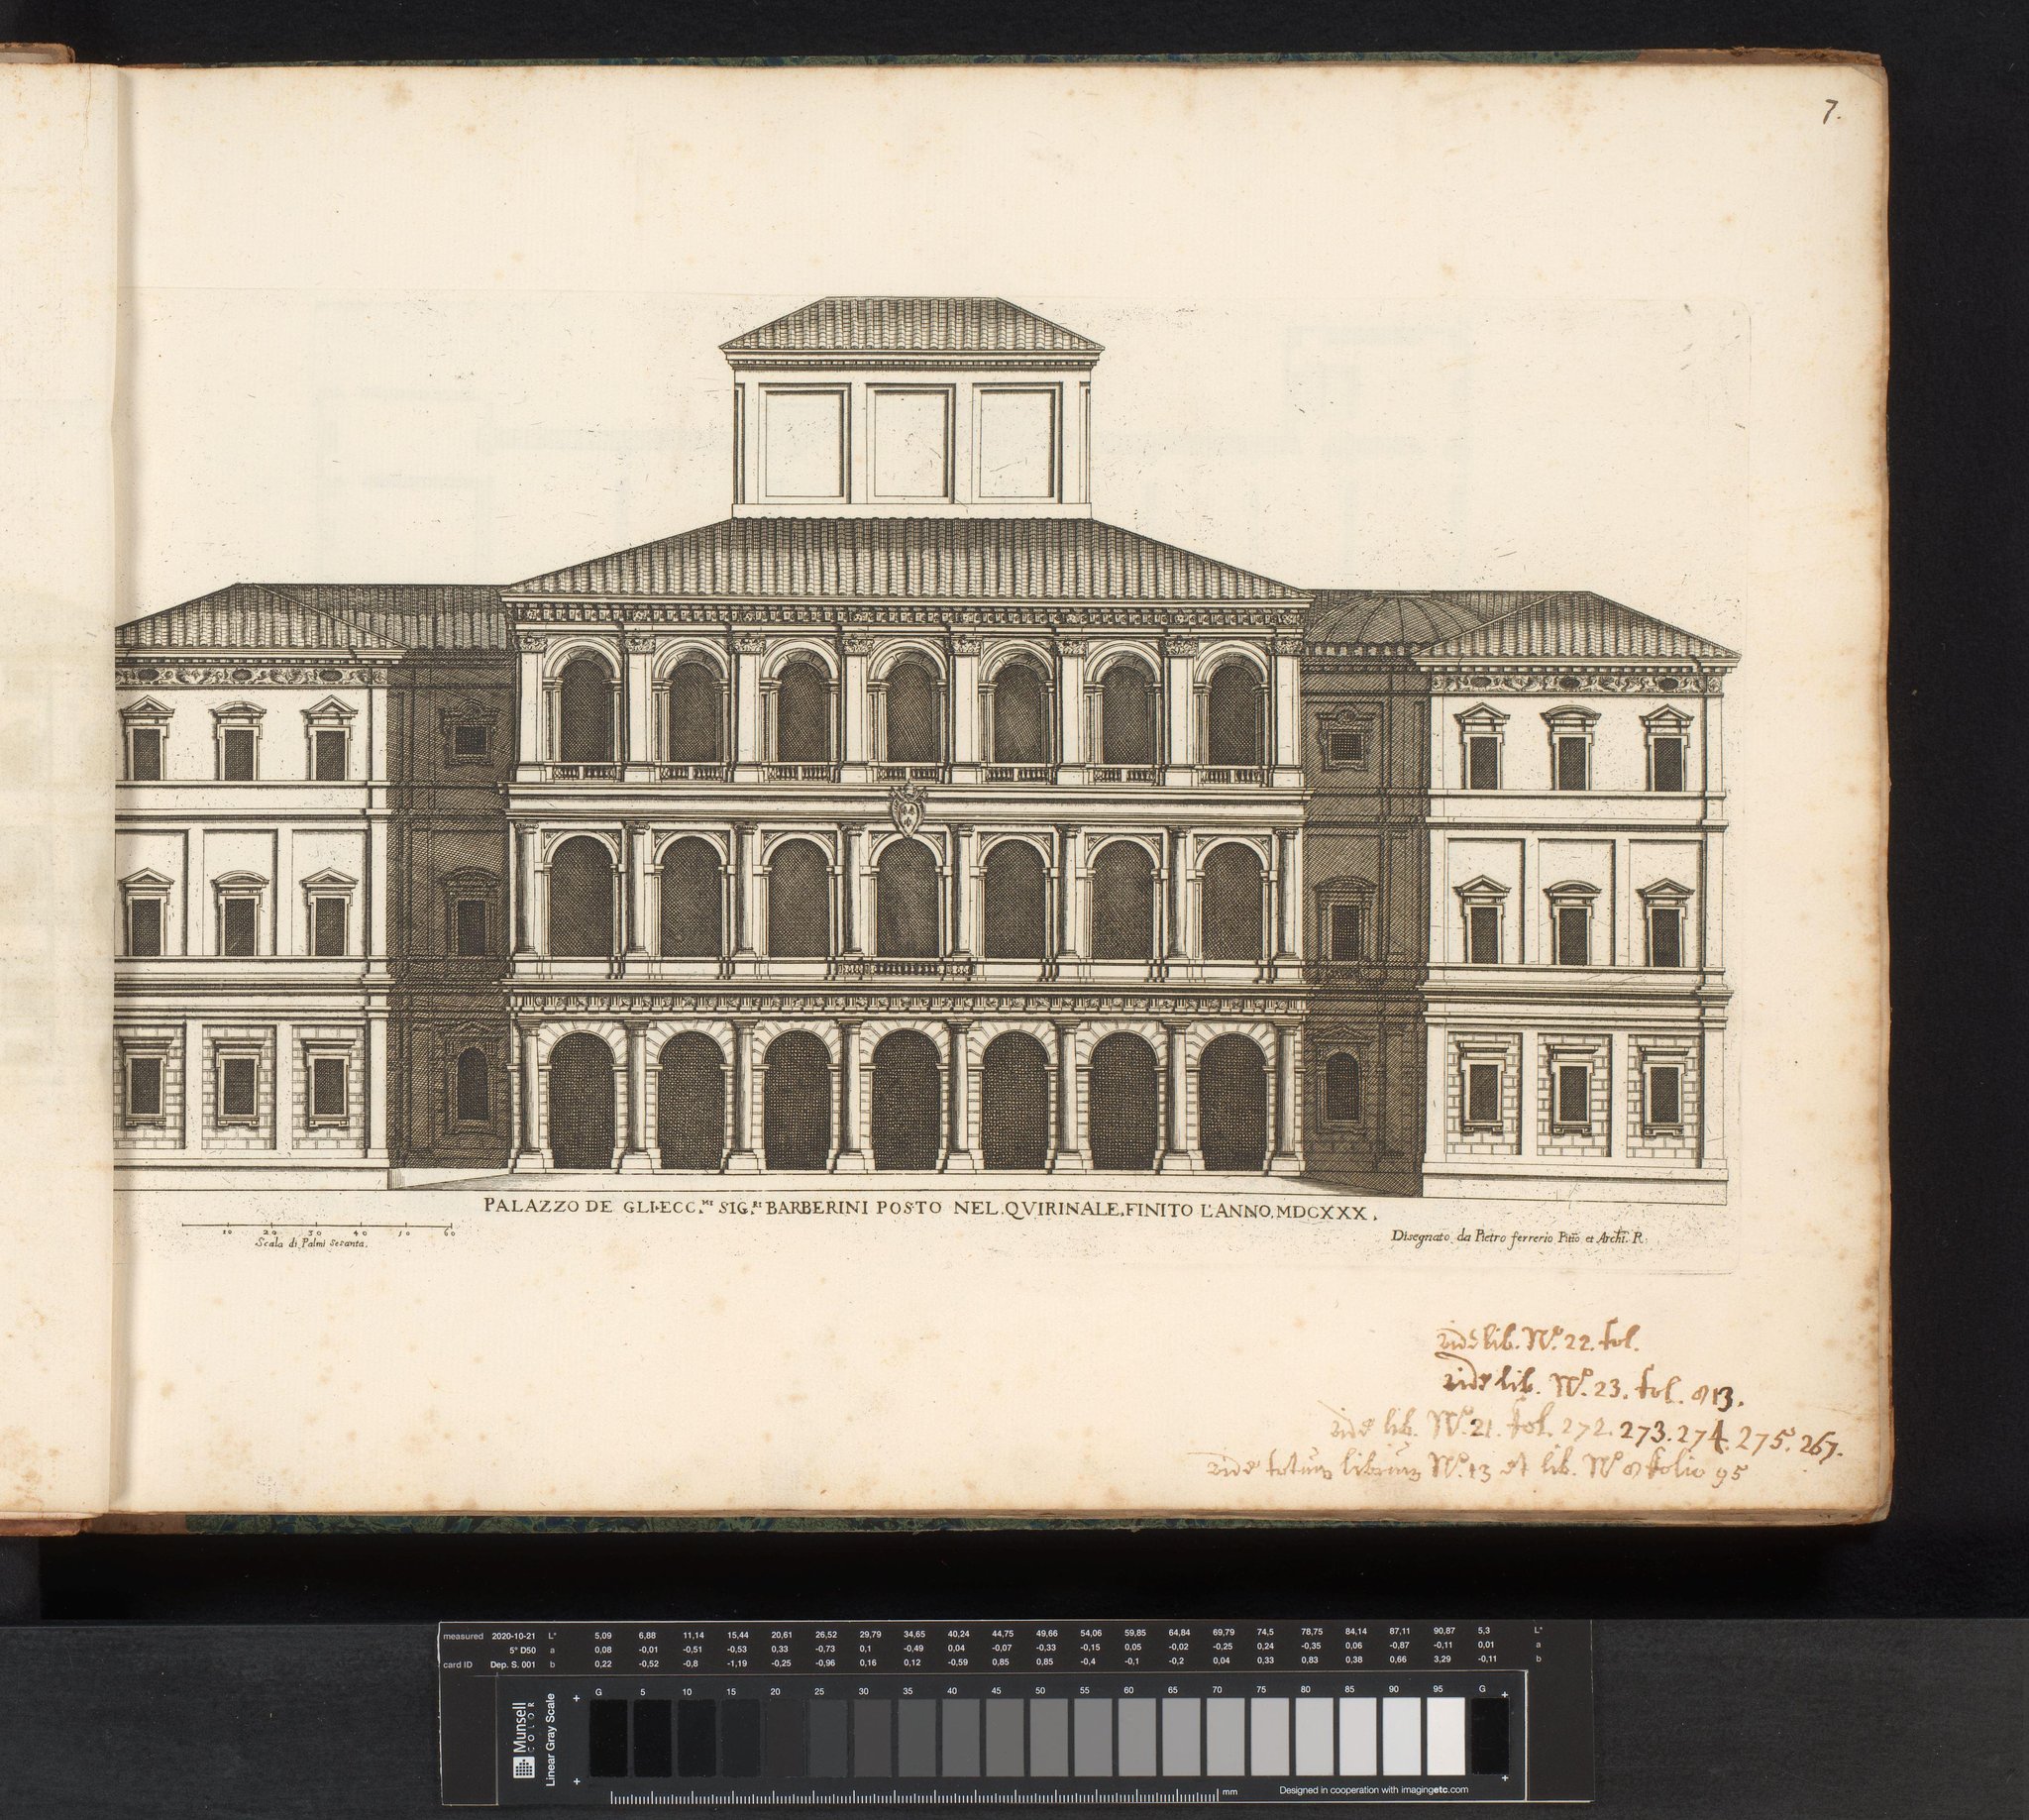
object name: album leaf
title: Palazzi di Roma dei più celebri architett (...)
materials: paper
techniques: etching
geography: italy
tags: palace, façade (of house or building)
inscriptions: inscription: ‘Ende lib. No. 22. fol./ Ende lib. No. 23. fol. 813...’, number: ‘7’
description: Deze prent maakt deel uit van de reeks getiteld: Palazzi di Roma. Deze reeks bestaat uit twee boeken. Boek één getiteld: Palazzi di Roma dei più celebri architetti..., bestaat uit 44 prenten die worden toegeschreven aan Giovanni Battista Falda (naam staat enkel op prent 27) en uitgegeven door Giovanni Giacomo de'Rossi. Deze 44 prenten zijn bekend in twee staten (met en zonder nummer). Boek twee getiteld: Nuovi disegni dell'architetture... libro secondo, bevat 66 prenten door Giovanni Battista Falda en Simone Felice. Deze 66 prenten zijn bekend in twee staten (met en zonder nummer).